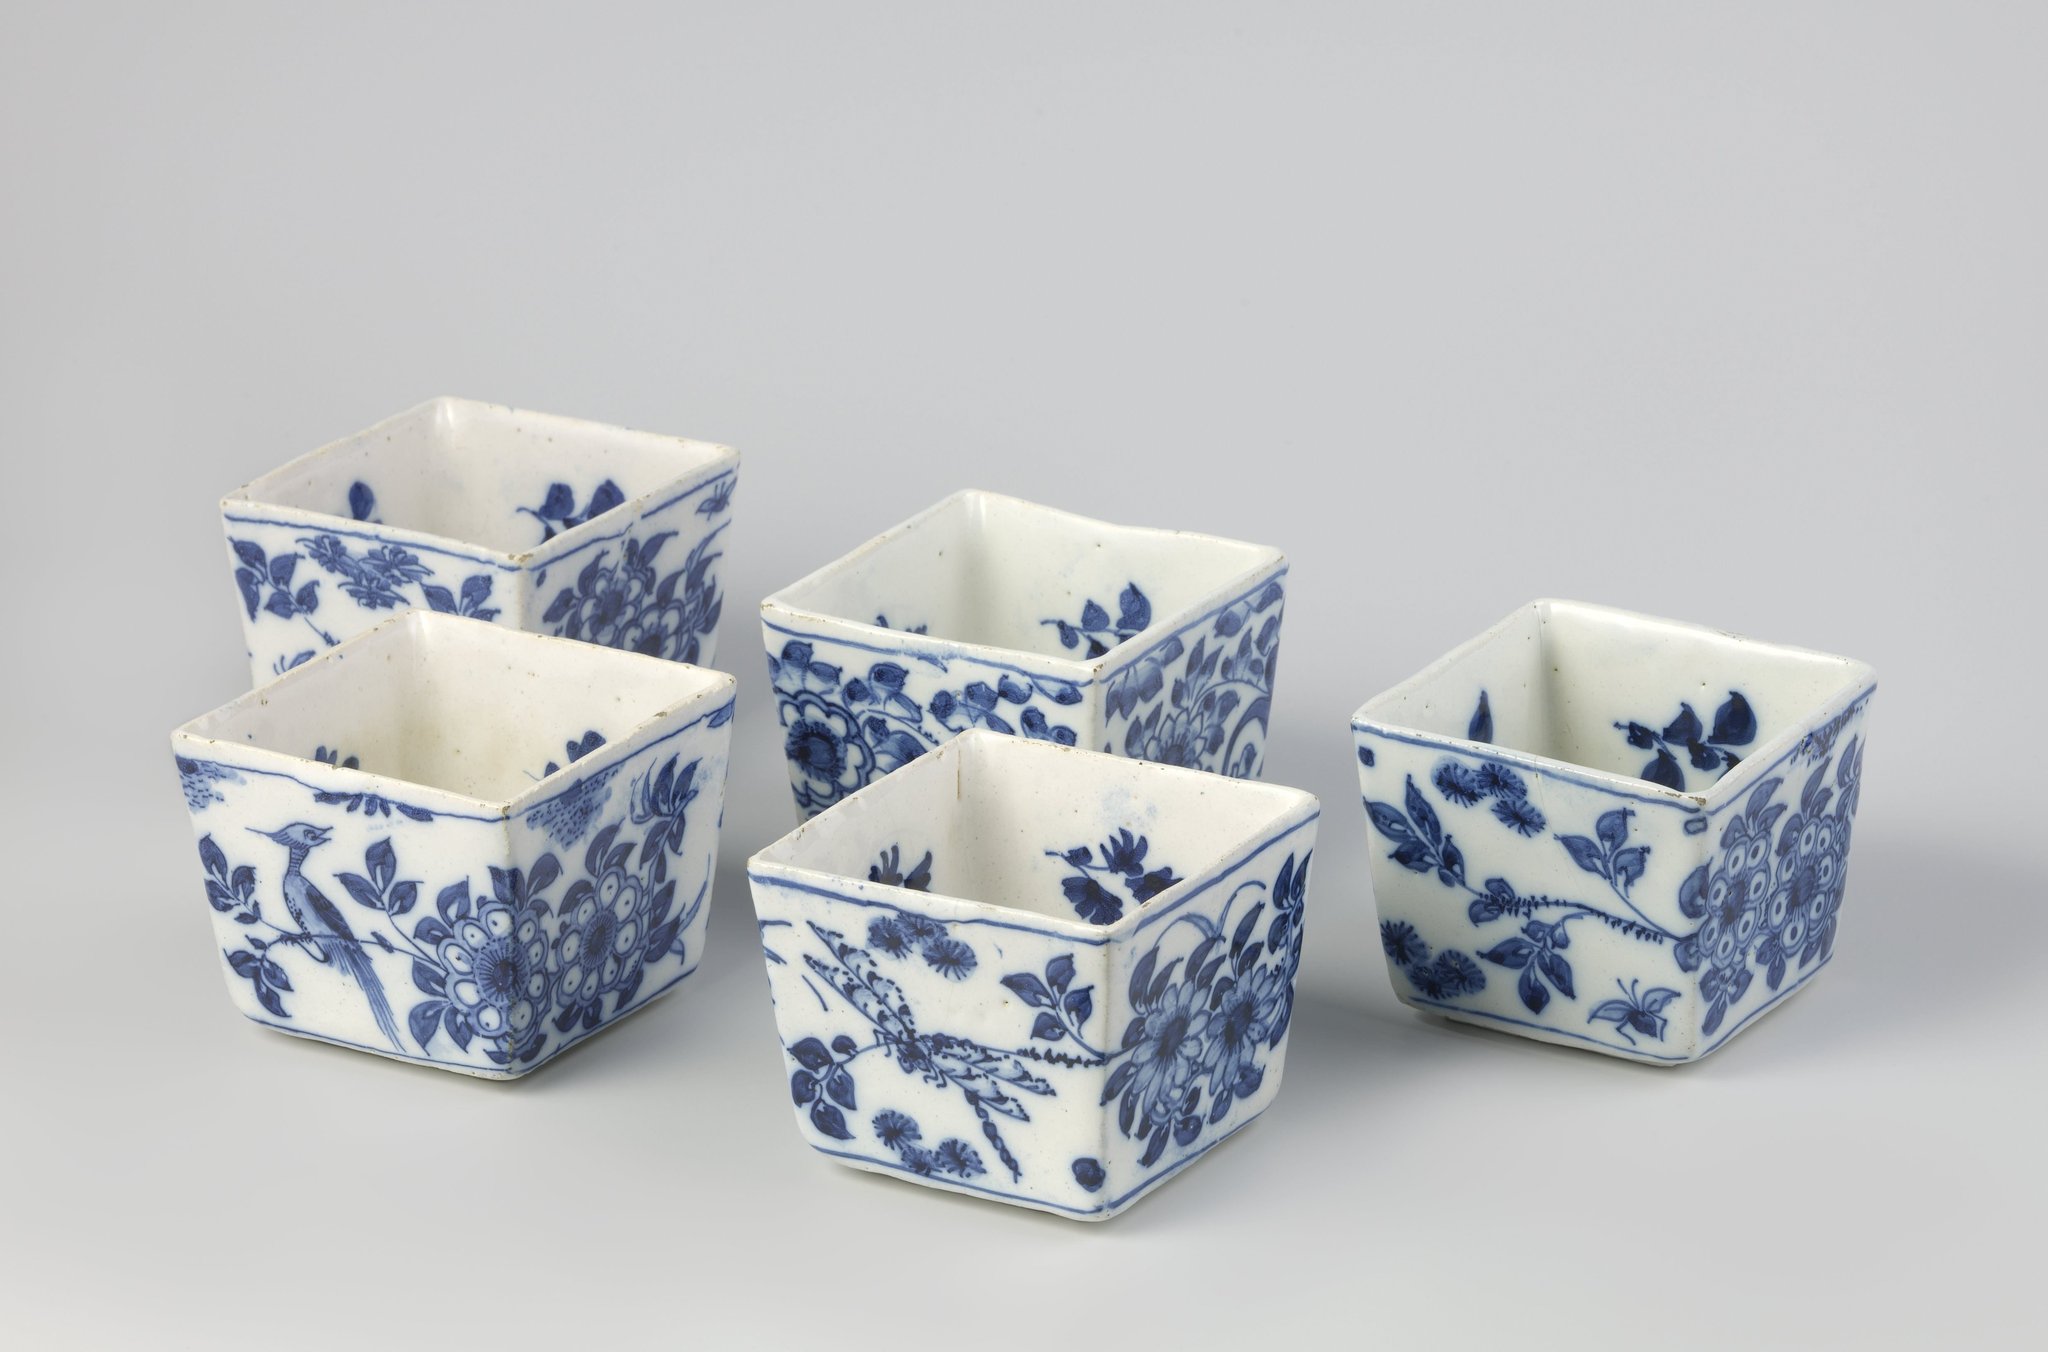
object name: case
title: Set of mukozuke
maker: Anonymous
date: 1670-1690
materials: earthenware, glaze, wood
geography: delft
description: The VOC ordered a great deal of porcelain in Japan, but occasionally Japanese patrons commissioned pottery made in Delft. These were small plates or dishes, mukozuke, which were used for the light meal preceding the tea ceremony. The Japanese tea master could cut a dash for his guests with these exclusive goods from the faraway Low Countries.